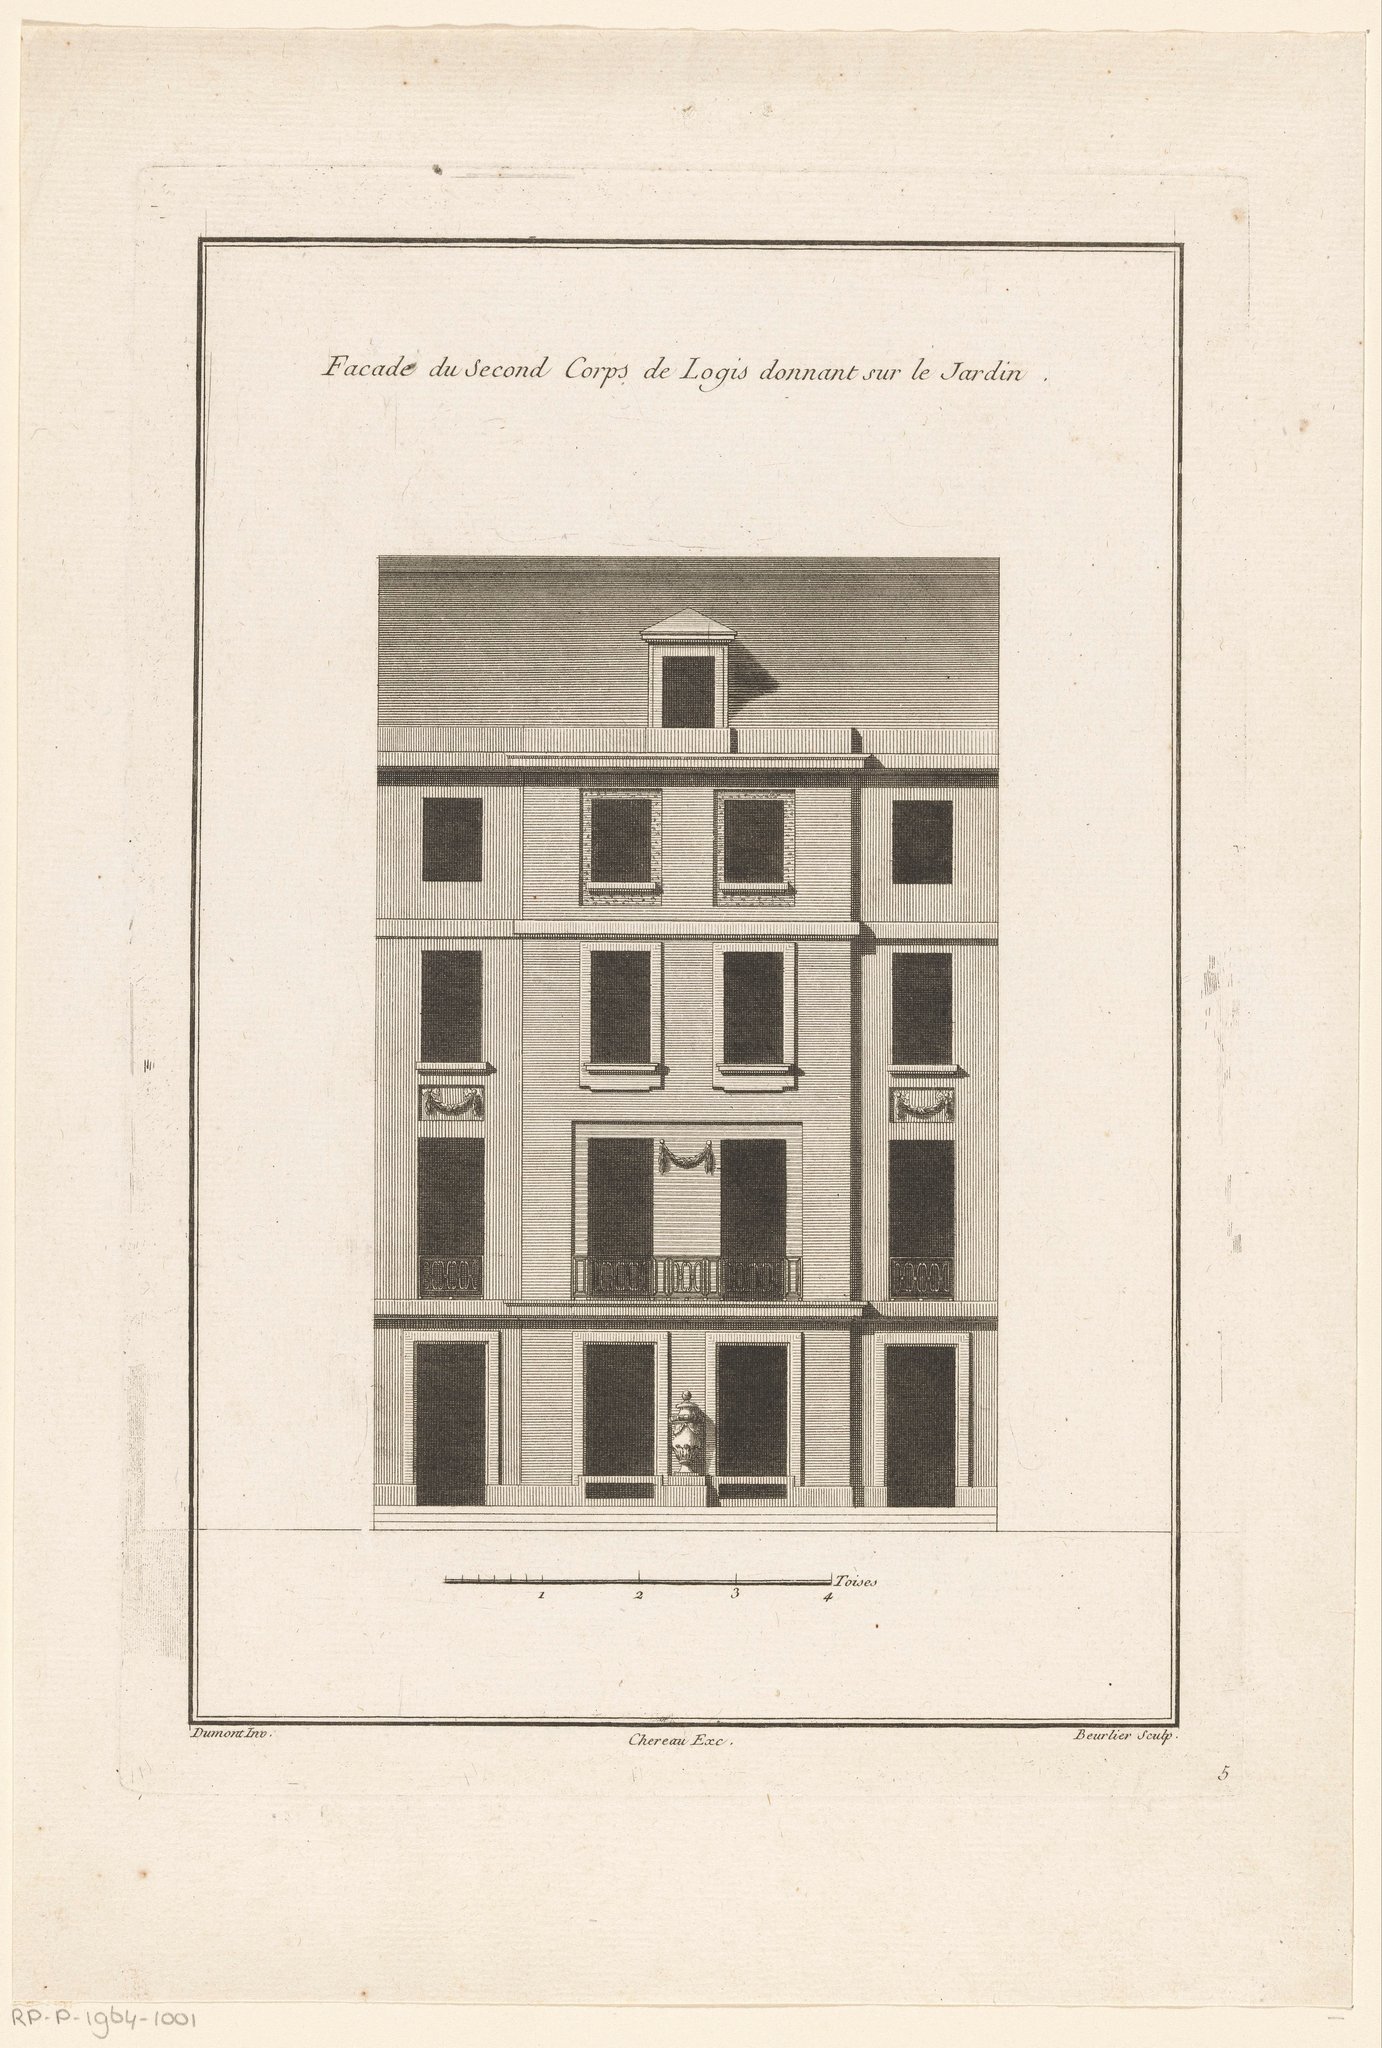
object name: print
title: Facade du Second Corps de Logis donnant sur le Jardin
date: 1730-1790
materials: paper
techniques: engraving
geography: paris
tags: façade (of house or building)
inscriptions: collector's mark: Lugt 2228, collector's mark: Lugt 2760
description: Façade van een huis met vier verdiepingen met een trappartij.